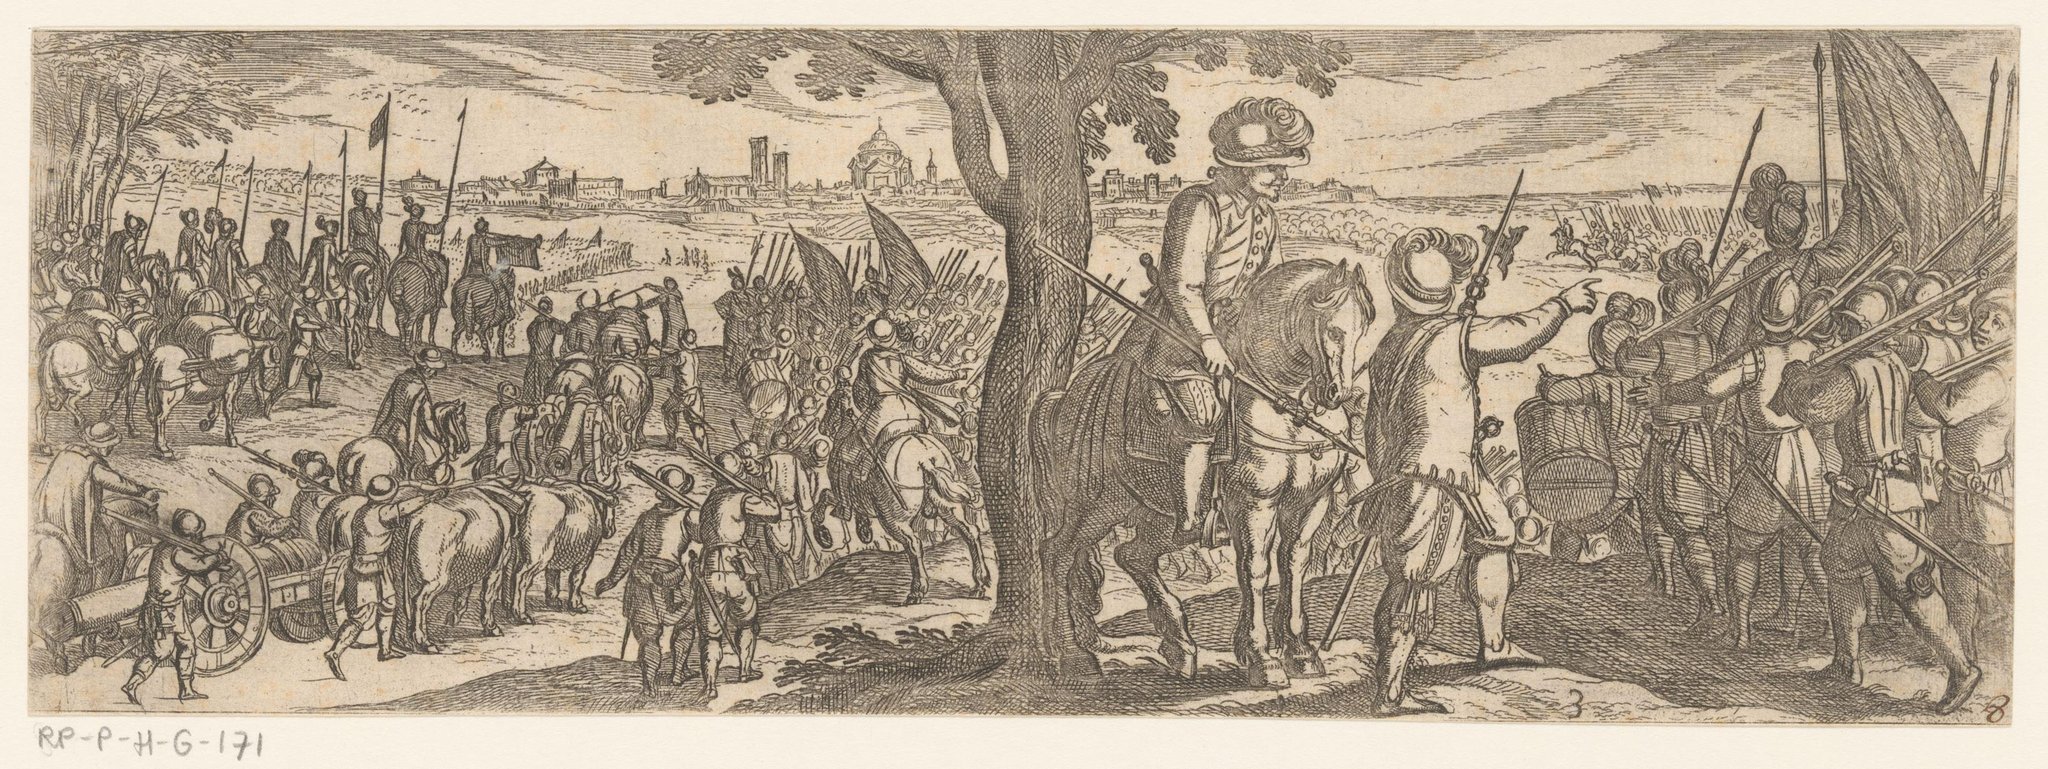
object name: print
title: Gevechtsscènes (serie 2)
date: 1599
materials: paper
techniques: etching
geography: italy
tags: warfare; military affairs (+ cavalry, horsemen), the soldier; the soldier's life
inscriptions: number: ‘8’, collector's mark: ‘Hinloopen’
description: Deze prent maakt deel uit van een reeks van 9 prenten (+ titelprent) met gevechtsscènes. Antonio Tempesta maakte ook een eerdere serie met gevechtsscènes van 10 prenten (+titelprent).